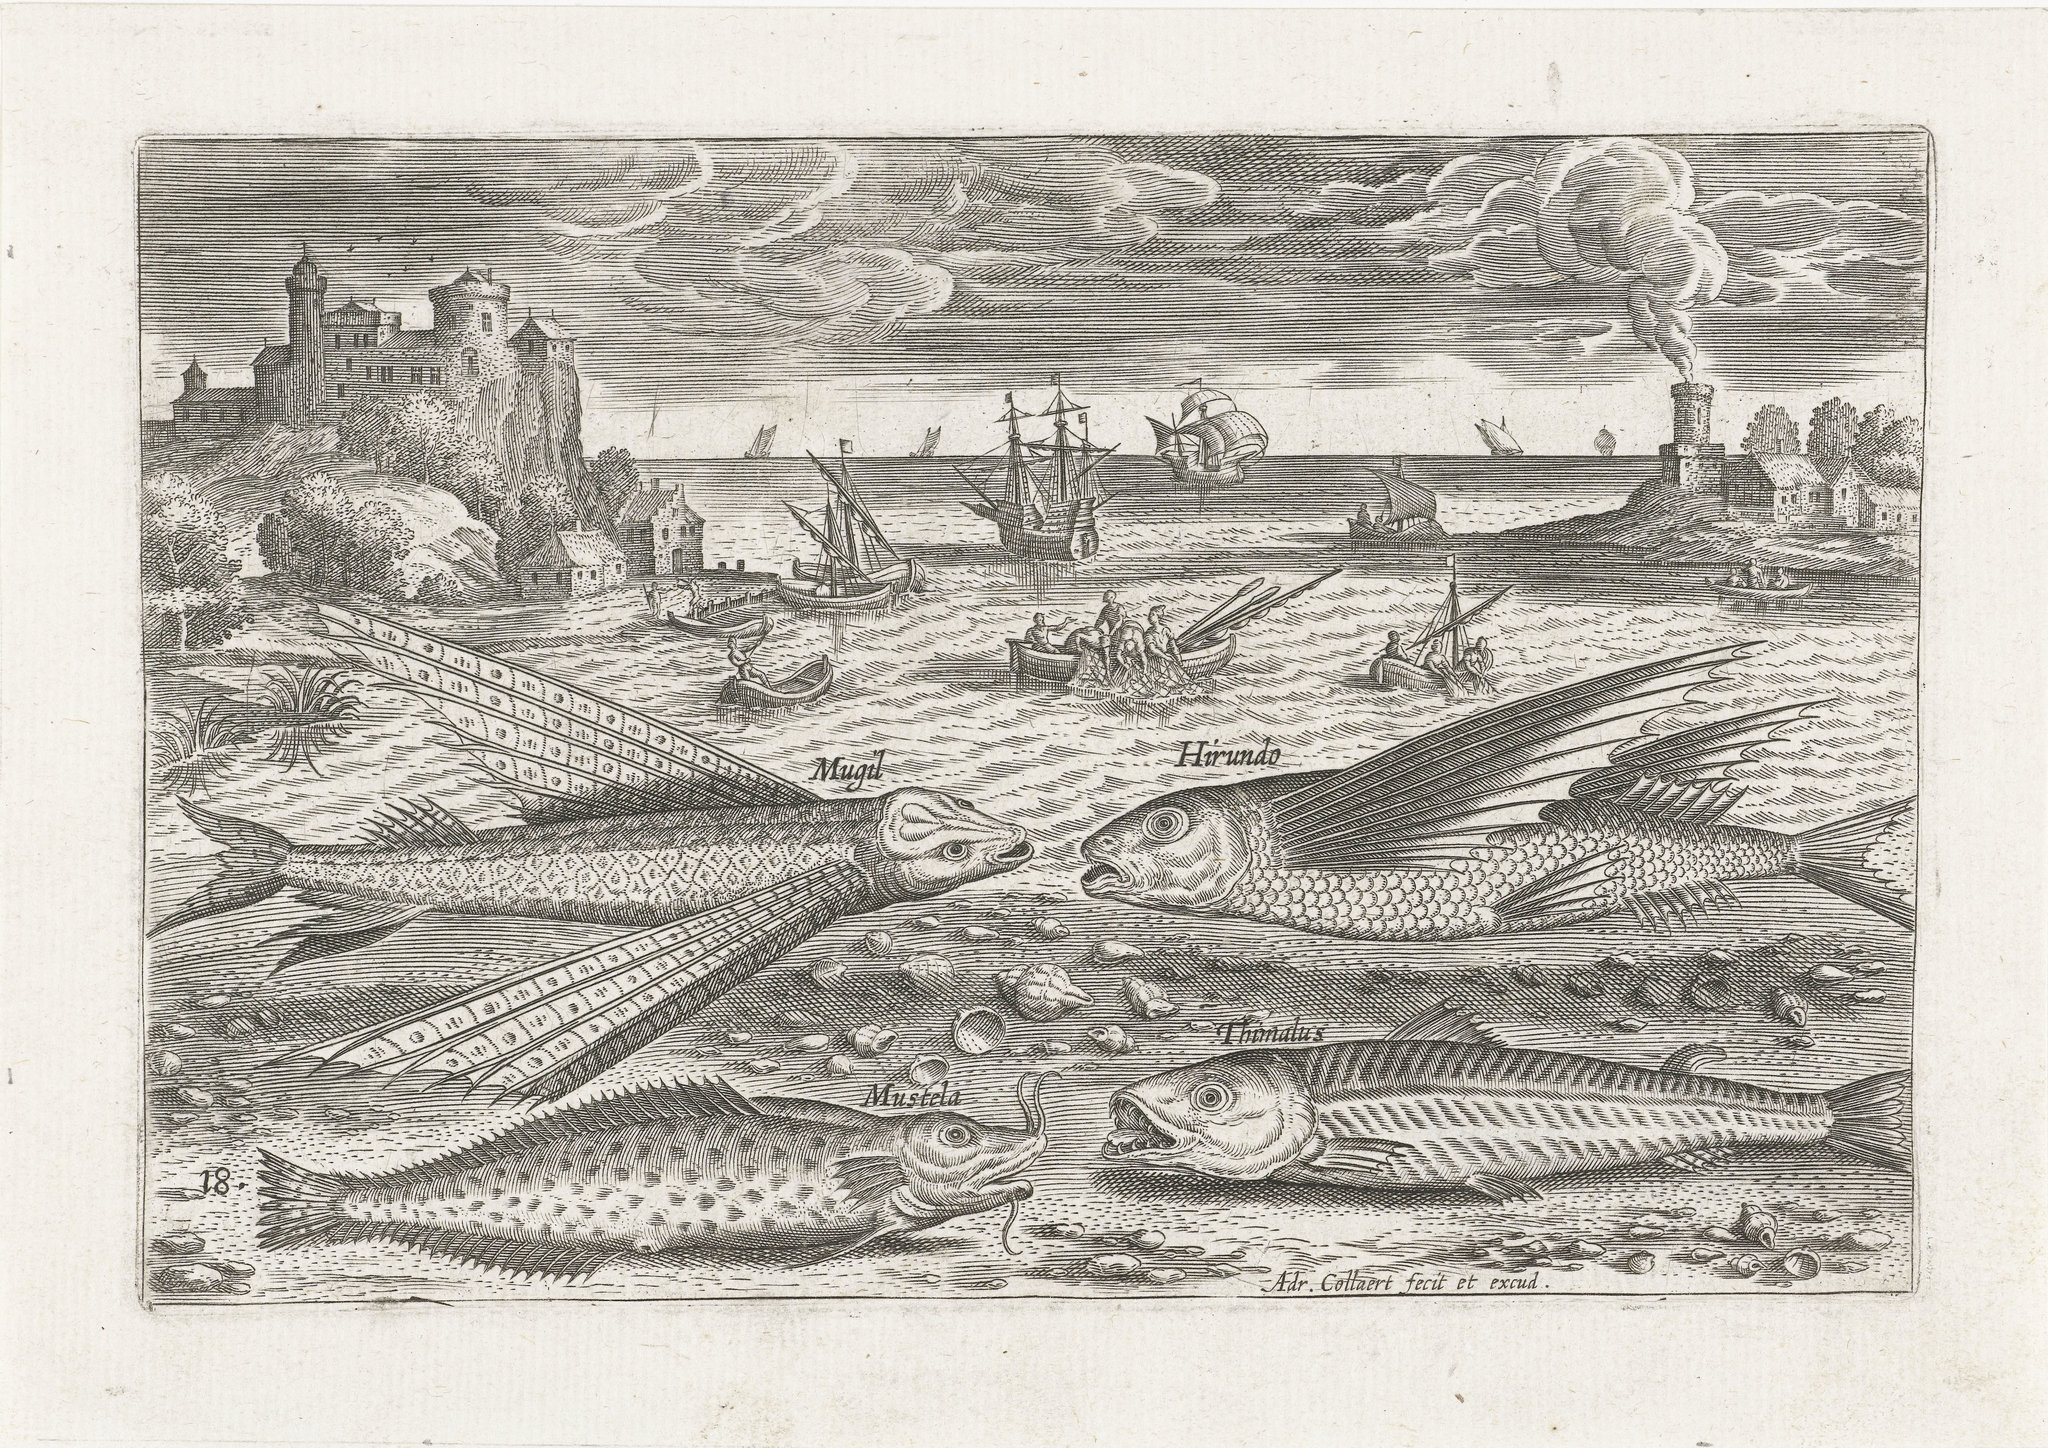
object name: print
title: Vissen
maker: adriaen collaert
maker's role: draughtsman, print maker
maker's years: 1560-1618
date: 1598-1618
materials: paper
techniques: engraving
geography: antwerp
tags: sea (seascape), bony fishes: gurnard, bony fishes: rockling, bony fishes: mugil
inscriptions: collector's mark: Lugt 2228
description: Een harder, een vliegende knorhaan, een lompje en een onbekende vis liggen samen met wat schelpen aangespoeld op het strand. Op de achtergrond een zee met enkele schepen. De prent maakt deel uit van een serie met vissen als onderwerp.